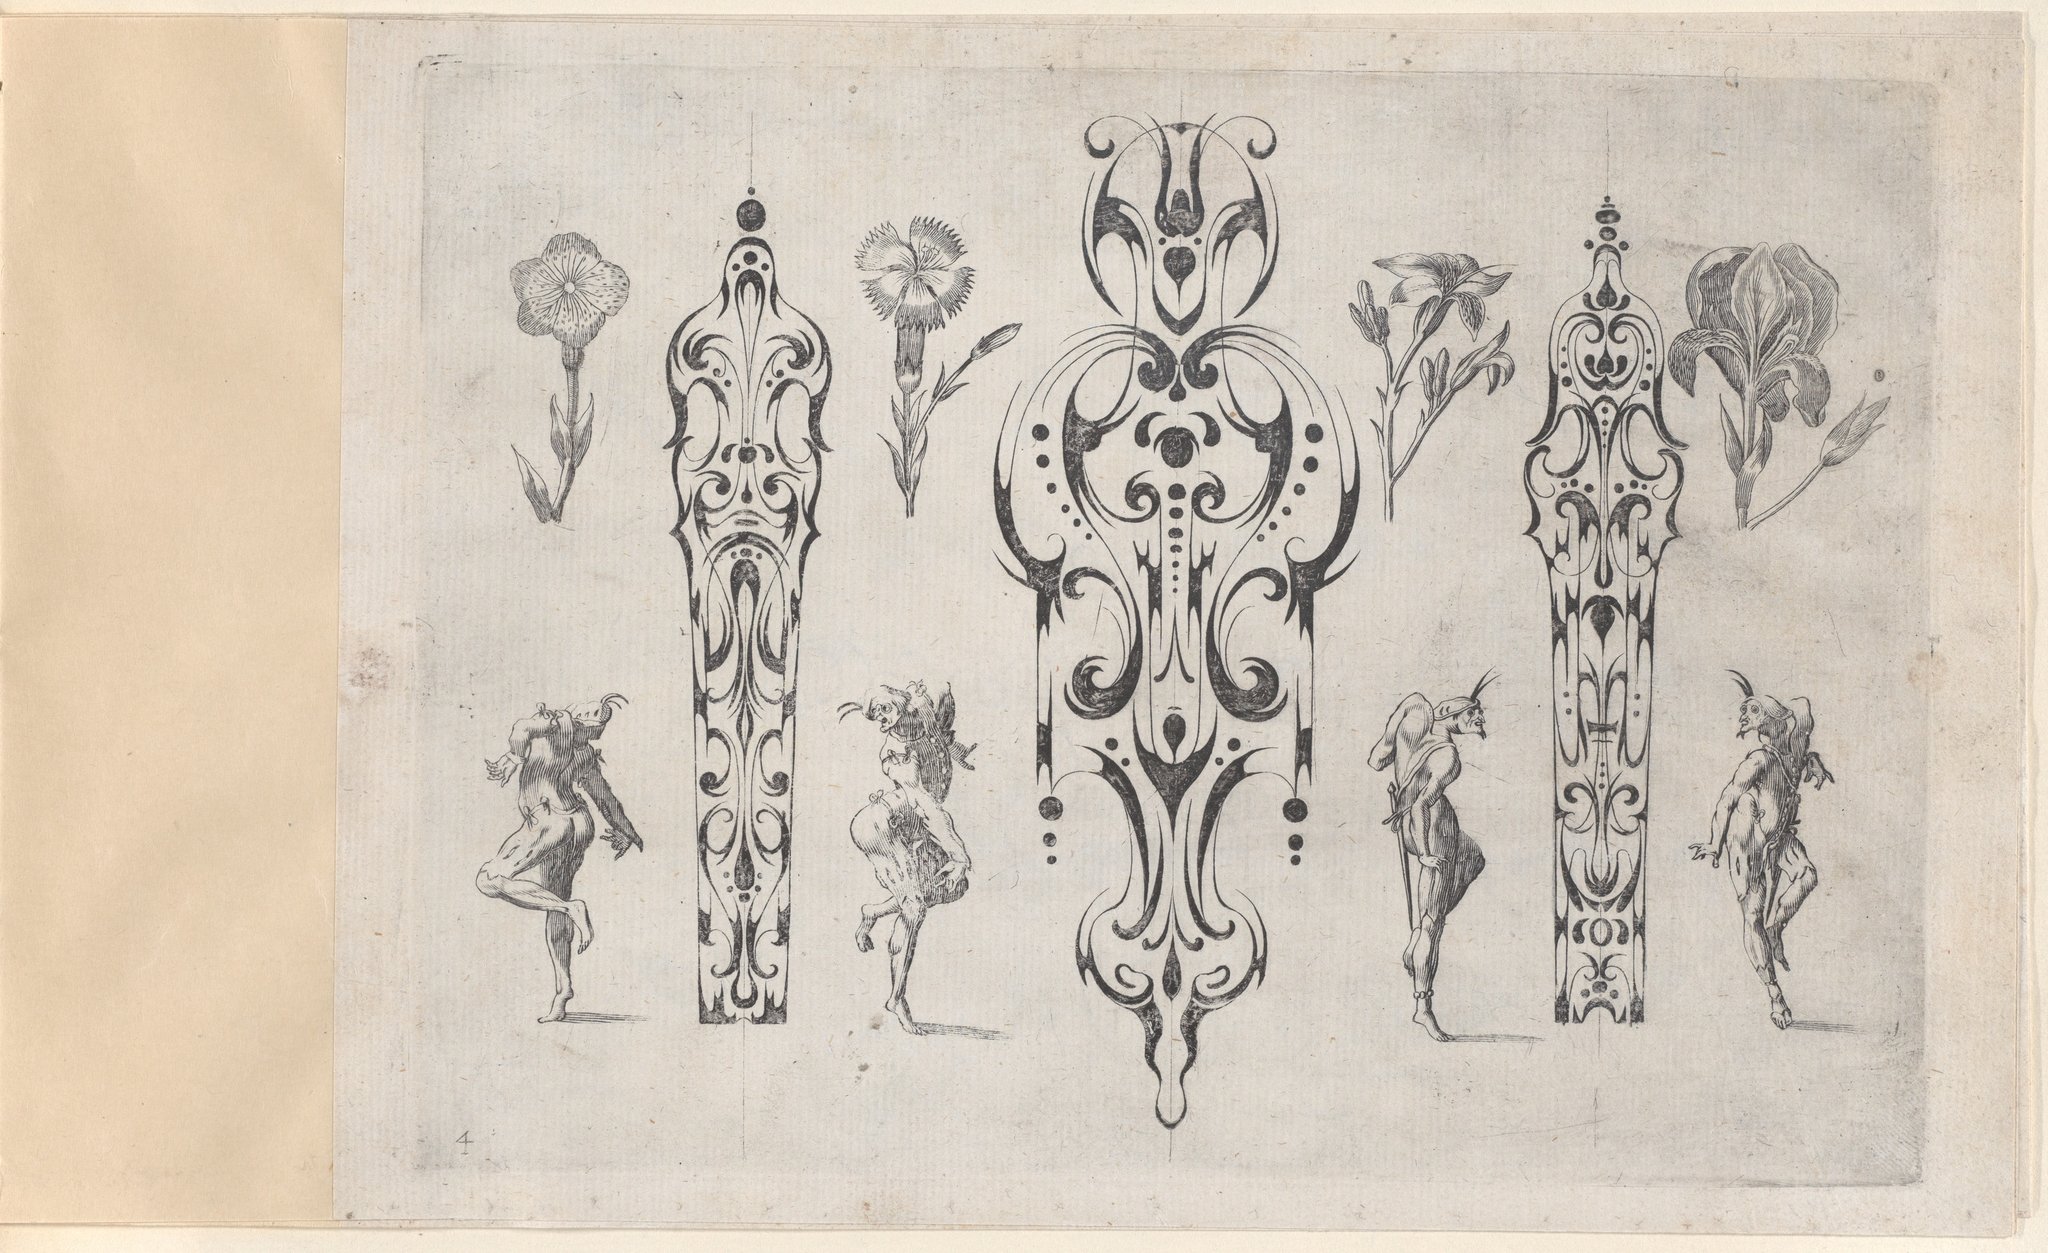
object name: album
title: Blackwork Designs with Flowers and Commedia dell'Arte Figures, Plate 4 from a Series of Blackwork Ornaments combined with Figures, Birds, Animals and Flowers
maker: meinert gelijs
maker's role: artist and engraver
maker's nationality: dutch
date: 1622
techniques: embroidery, engraving